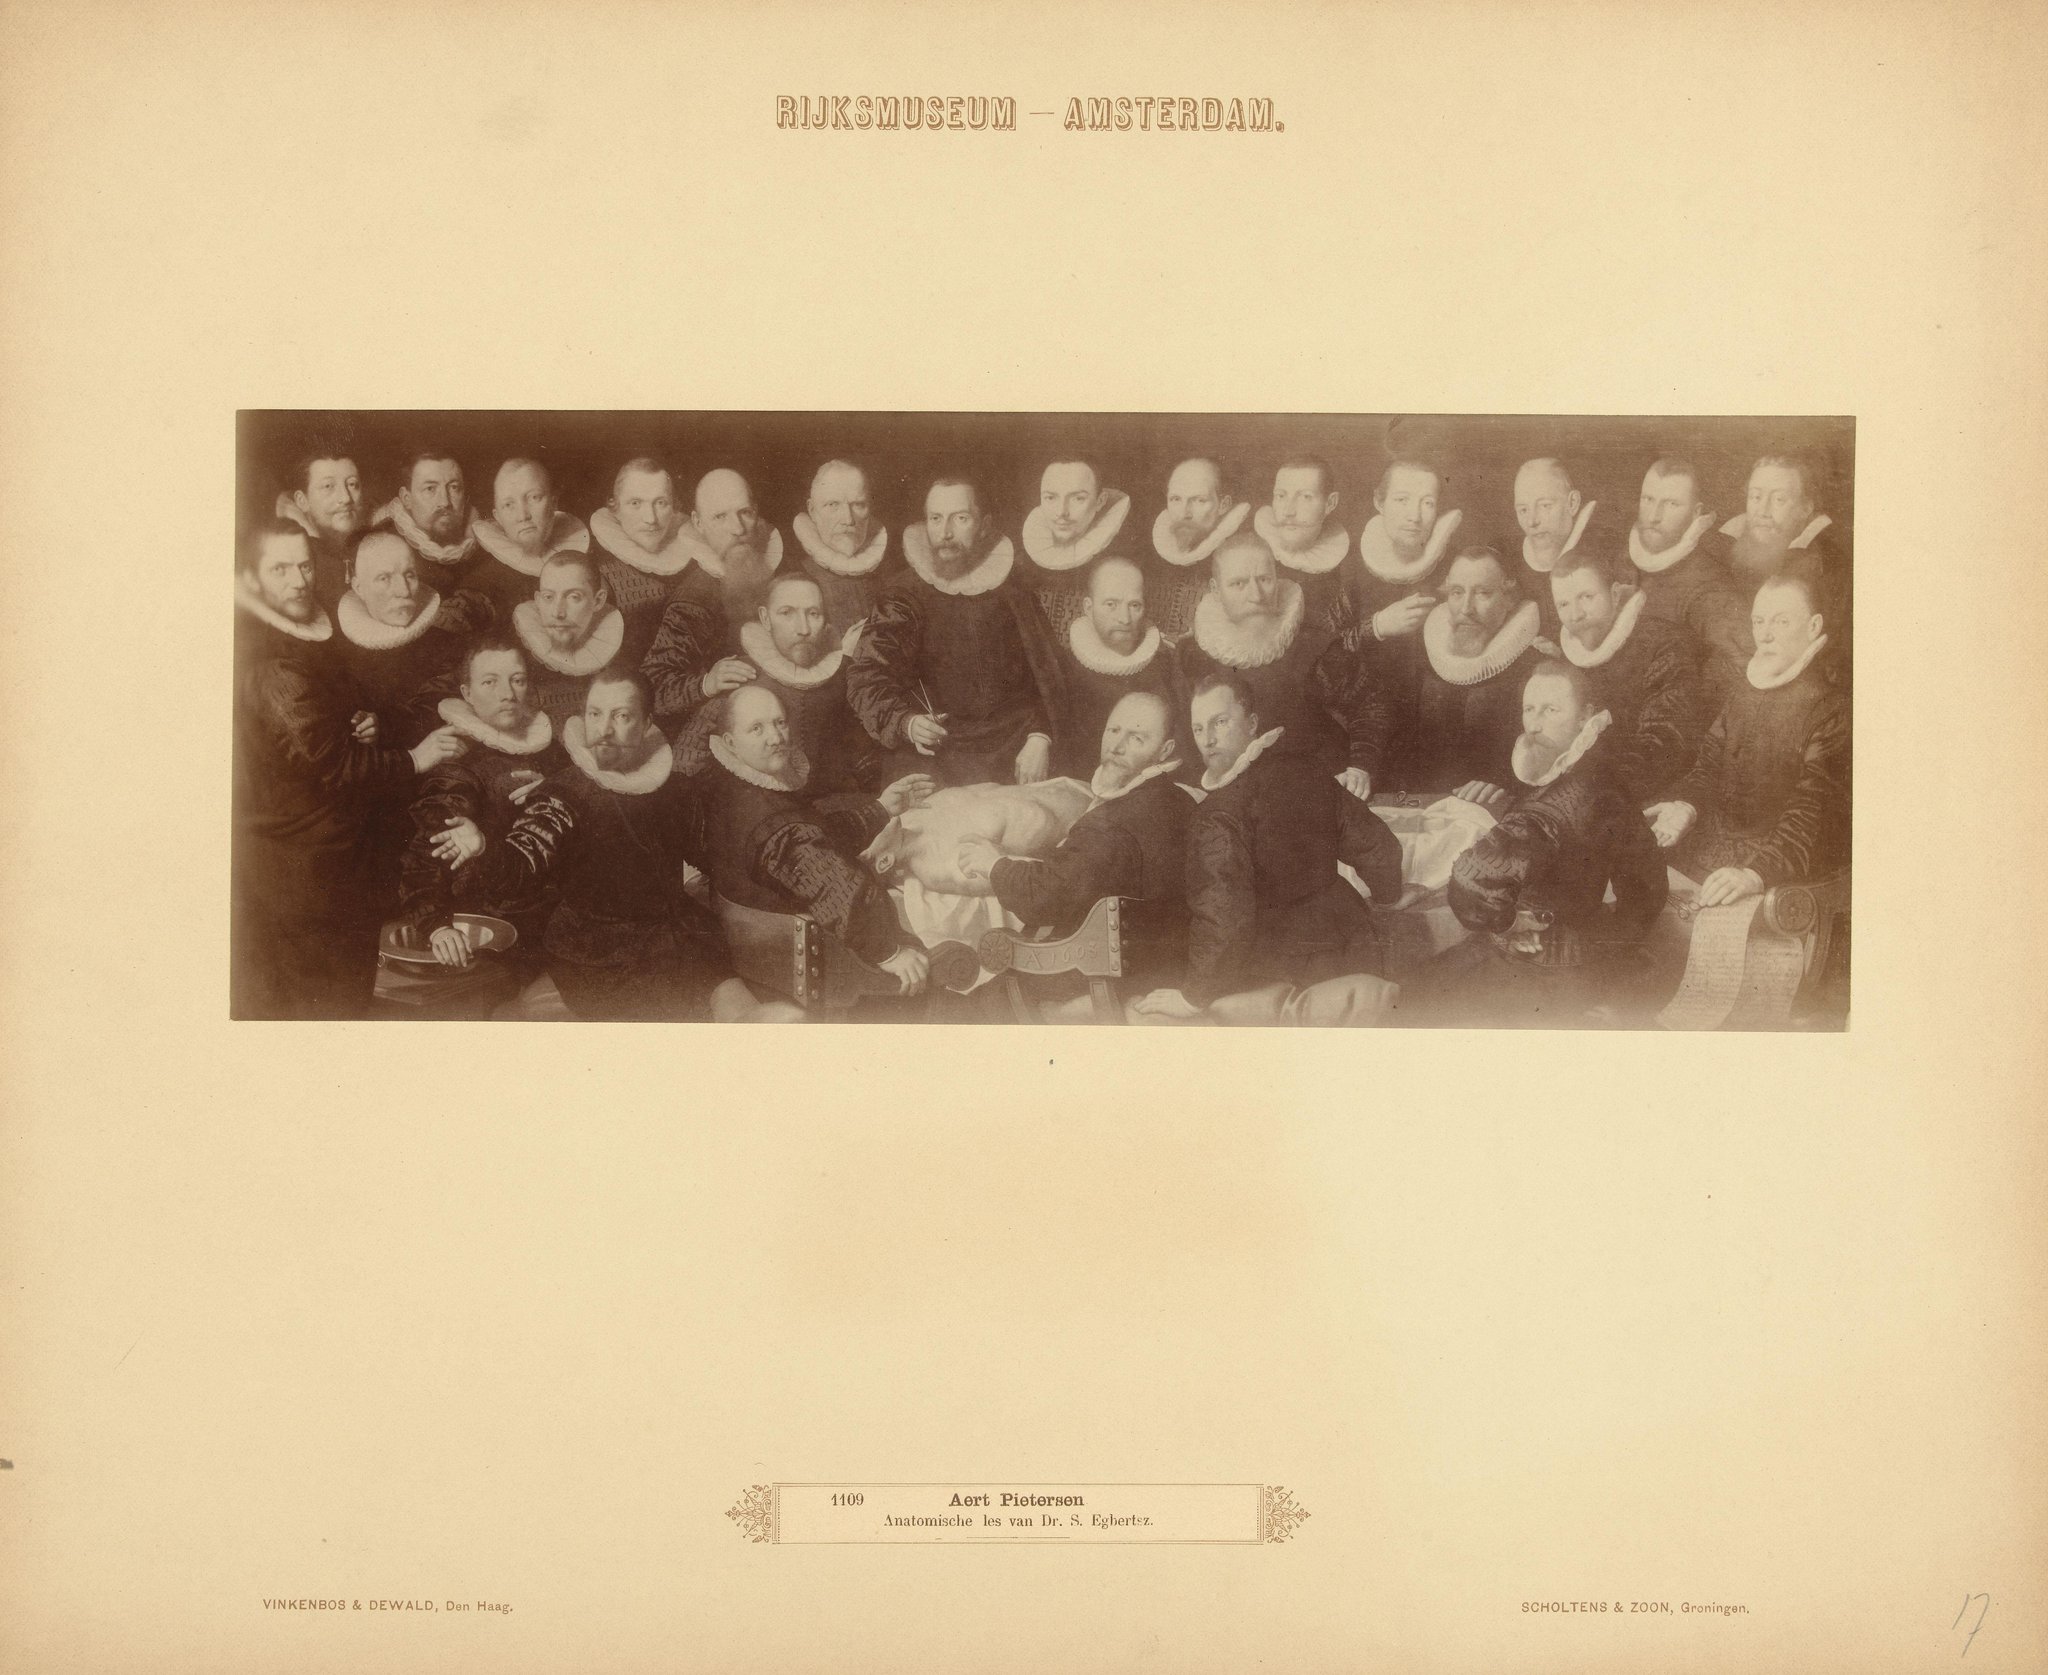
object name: photograph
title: Rijksmuseum - Amsterdam / 1109 Aert Pietersen Anatomische les van Dr. S. Egbertsz.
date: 1890-1910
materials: cardboard, paper, photographic support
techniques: albumen print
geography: the hague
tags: picture, painting